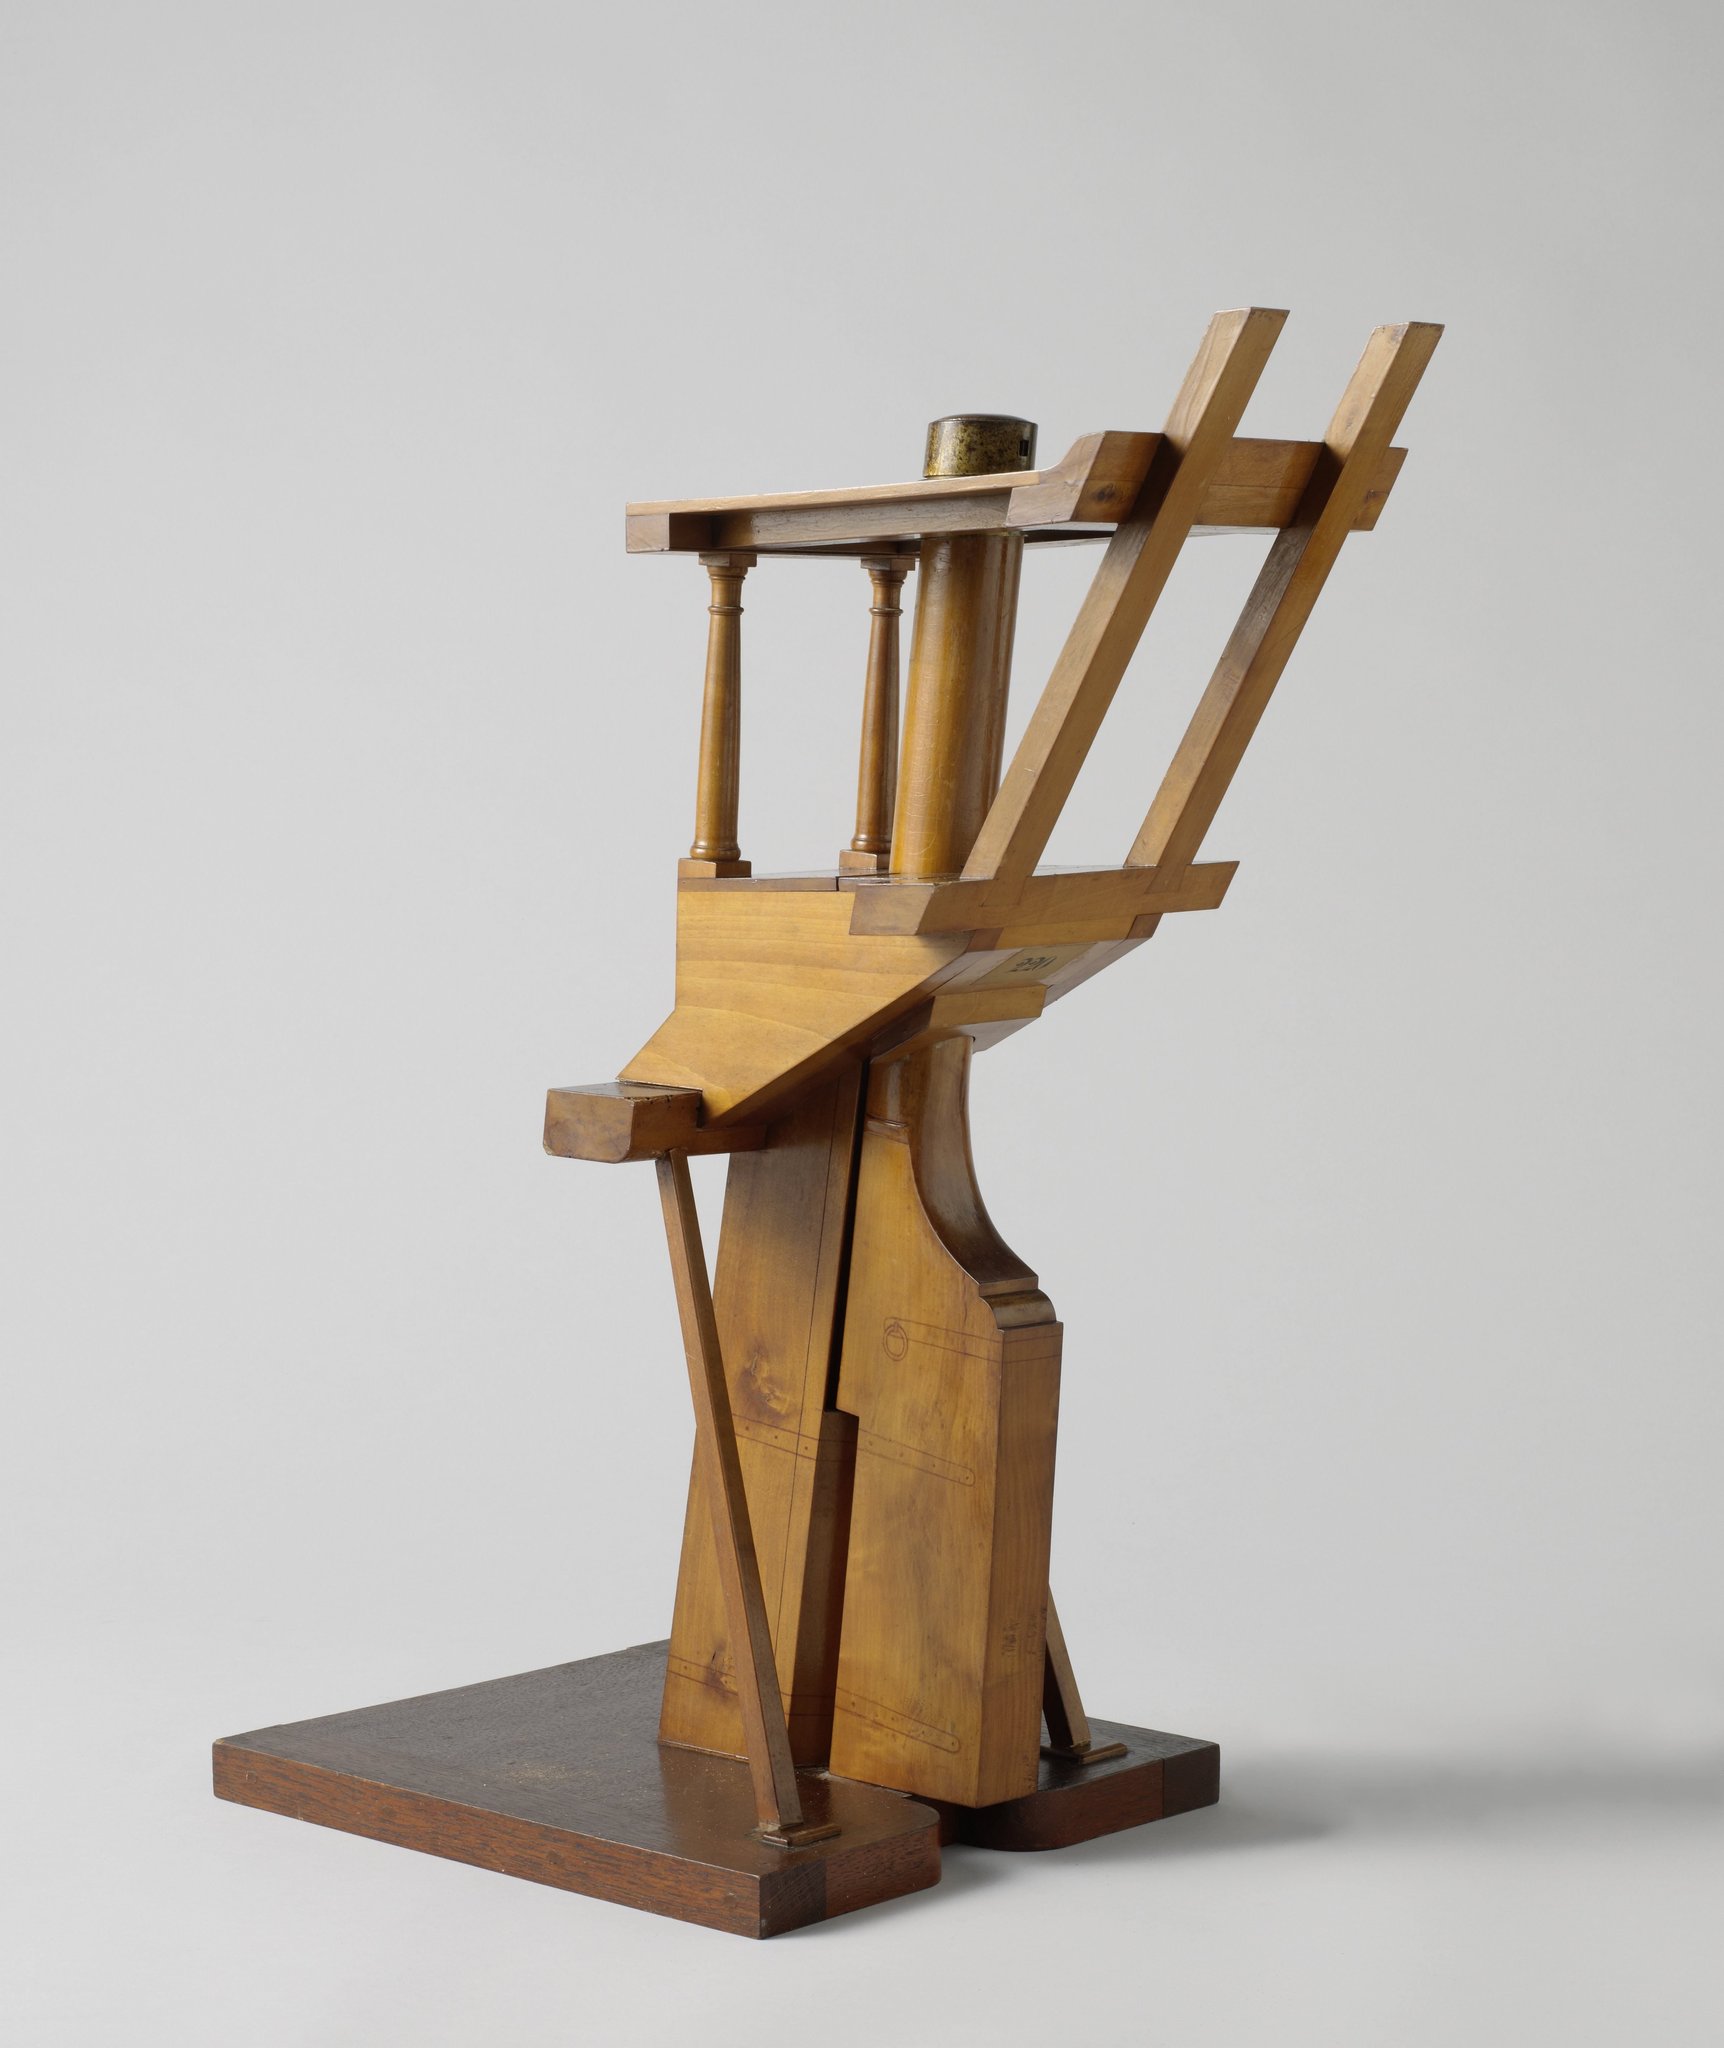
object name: demonstration model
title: Model of a Round-Headed Rudder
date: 1829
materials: brass, wood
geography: flushing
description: Model van het bovenstuk van een roer met achtersteven en wulfconstructie, op een grondplank. De roerkop, die erg lang is en doorloopt tot het bovendek, waar het gat voor de roerpen zit, springt naar voren en is rond. De messing van het roer is afgerond, die van de achtersteven is scherp onderaan, maar wordt hol waar de roerkop begint. Het hennegat wordt afgesloten met een los deel in het wulf. Eén roerijzer en de zorgband zijn ingekrast.